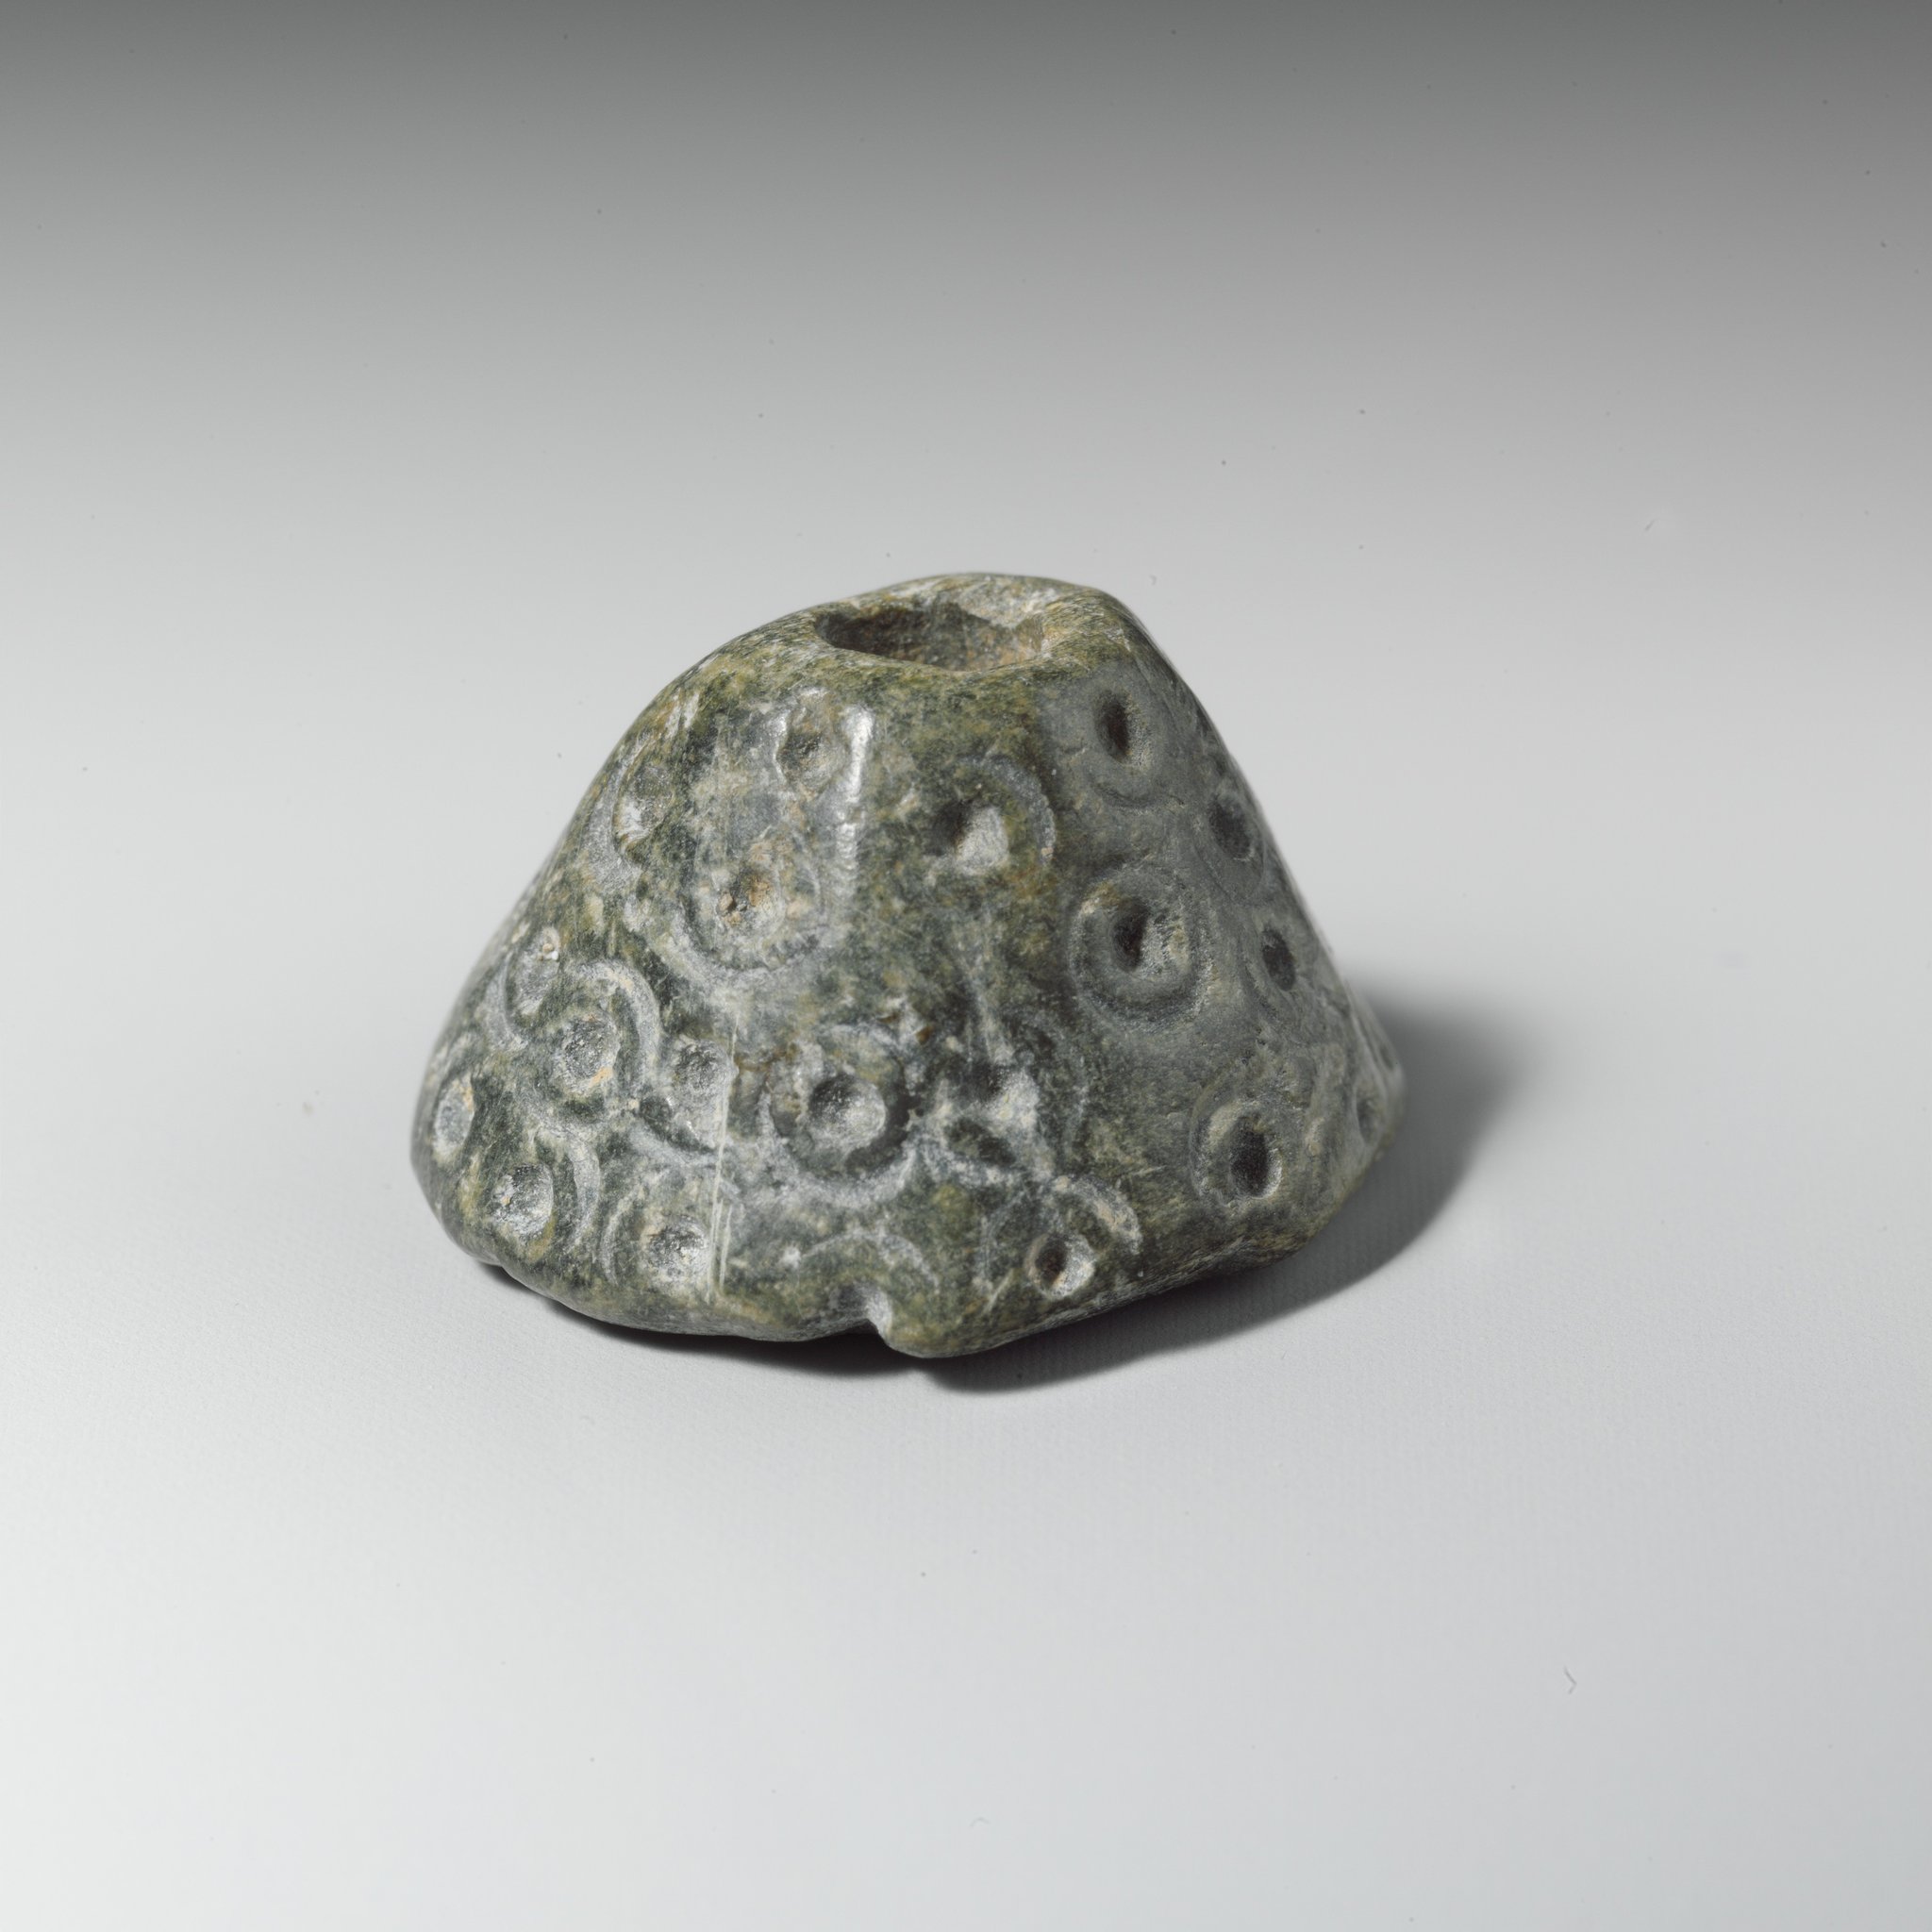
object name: spindle whorl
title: Steatite spindle whorl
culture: minoan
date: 2400-1900 BCE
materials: stone